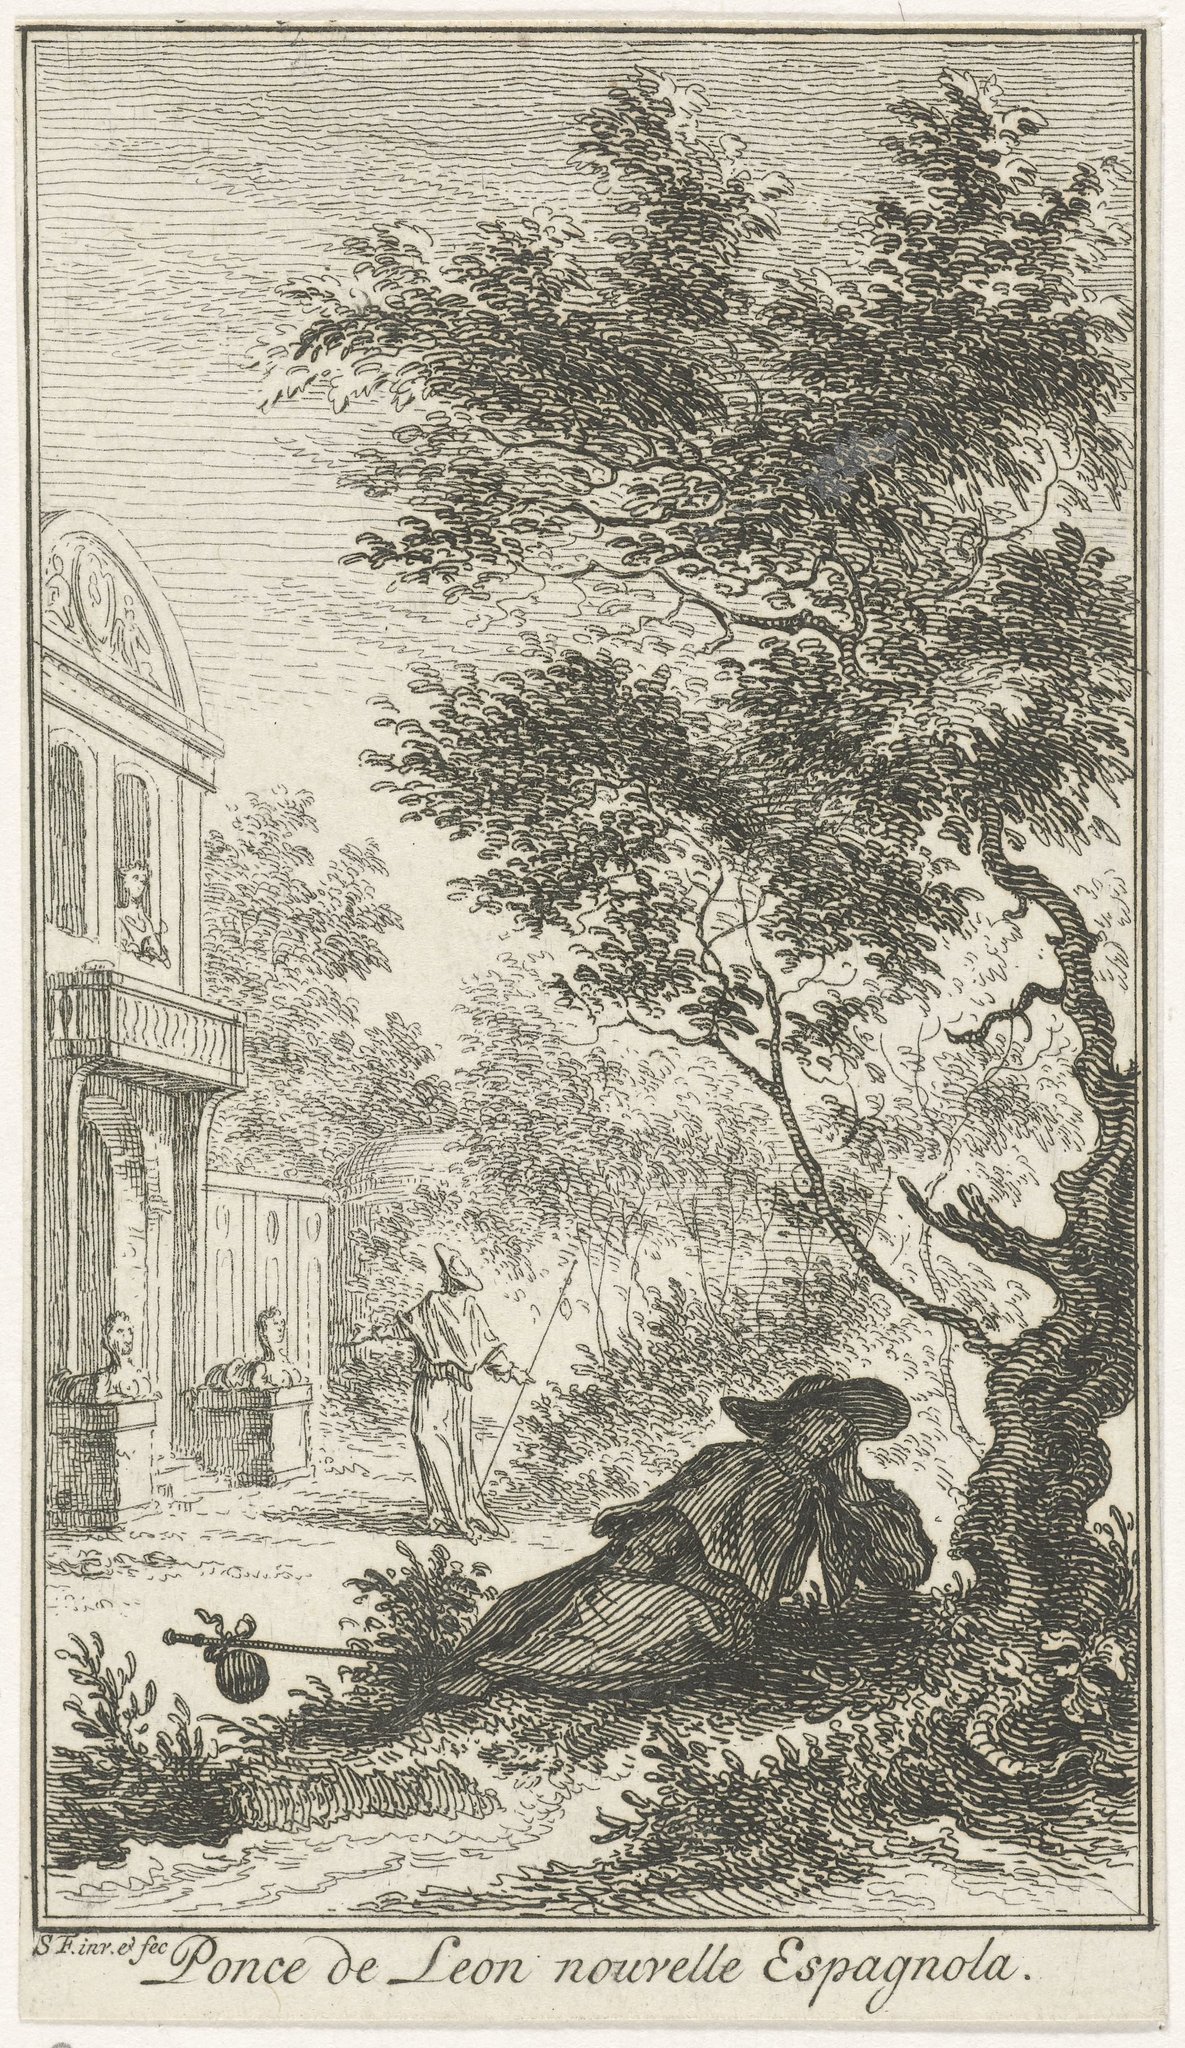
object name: print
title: Ponce de Leon nouvelle Espagnola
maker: simon fokke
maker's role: draughtsman, print maker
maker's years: 1712-1784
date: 1722-1784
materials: paper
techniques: etching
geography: amsterdam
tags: resting - bb - out of doors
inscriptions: collector's mark: Lugt 240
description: Illustratie uit het sprookje Ponce de Leon nouvelle Espagnola van Mme d'Aulnoy. Een man ligt onder een boom in de schaduw te rusten, naast hem ligt een knapzak op stok. Verderop staat een huis waar een man met een figuur communiceert die op de eerste verdieping in de raamopening staat.